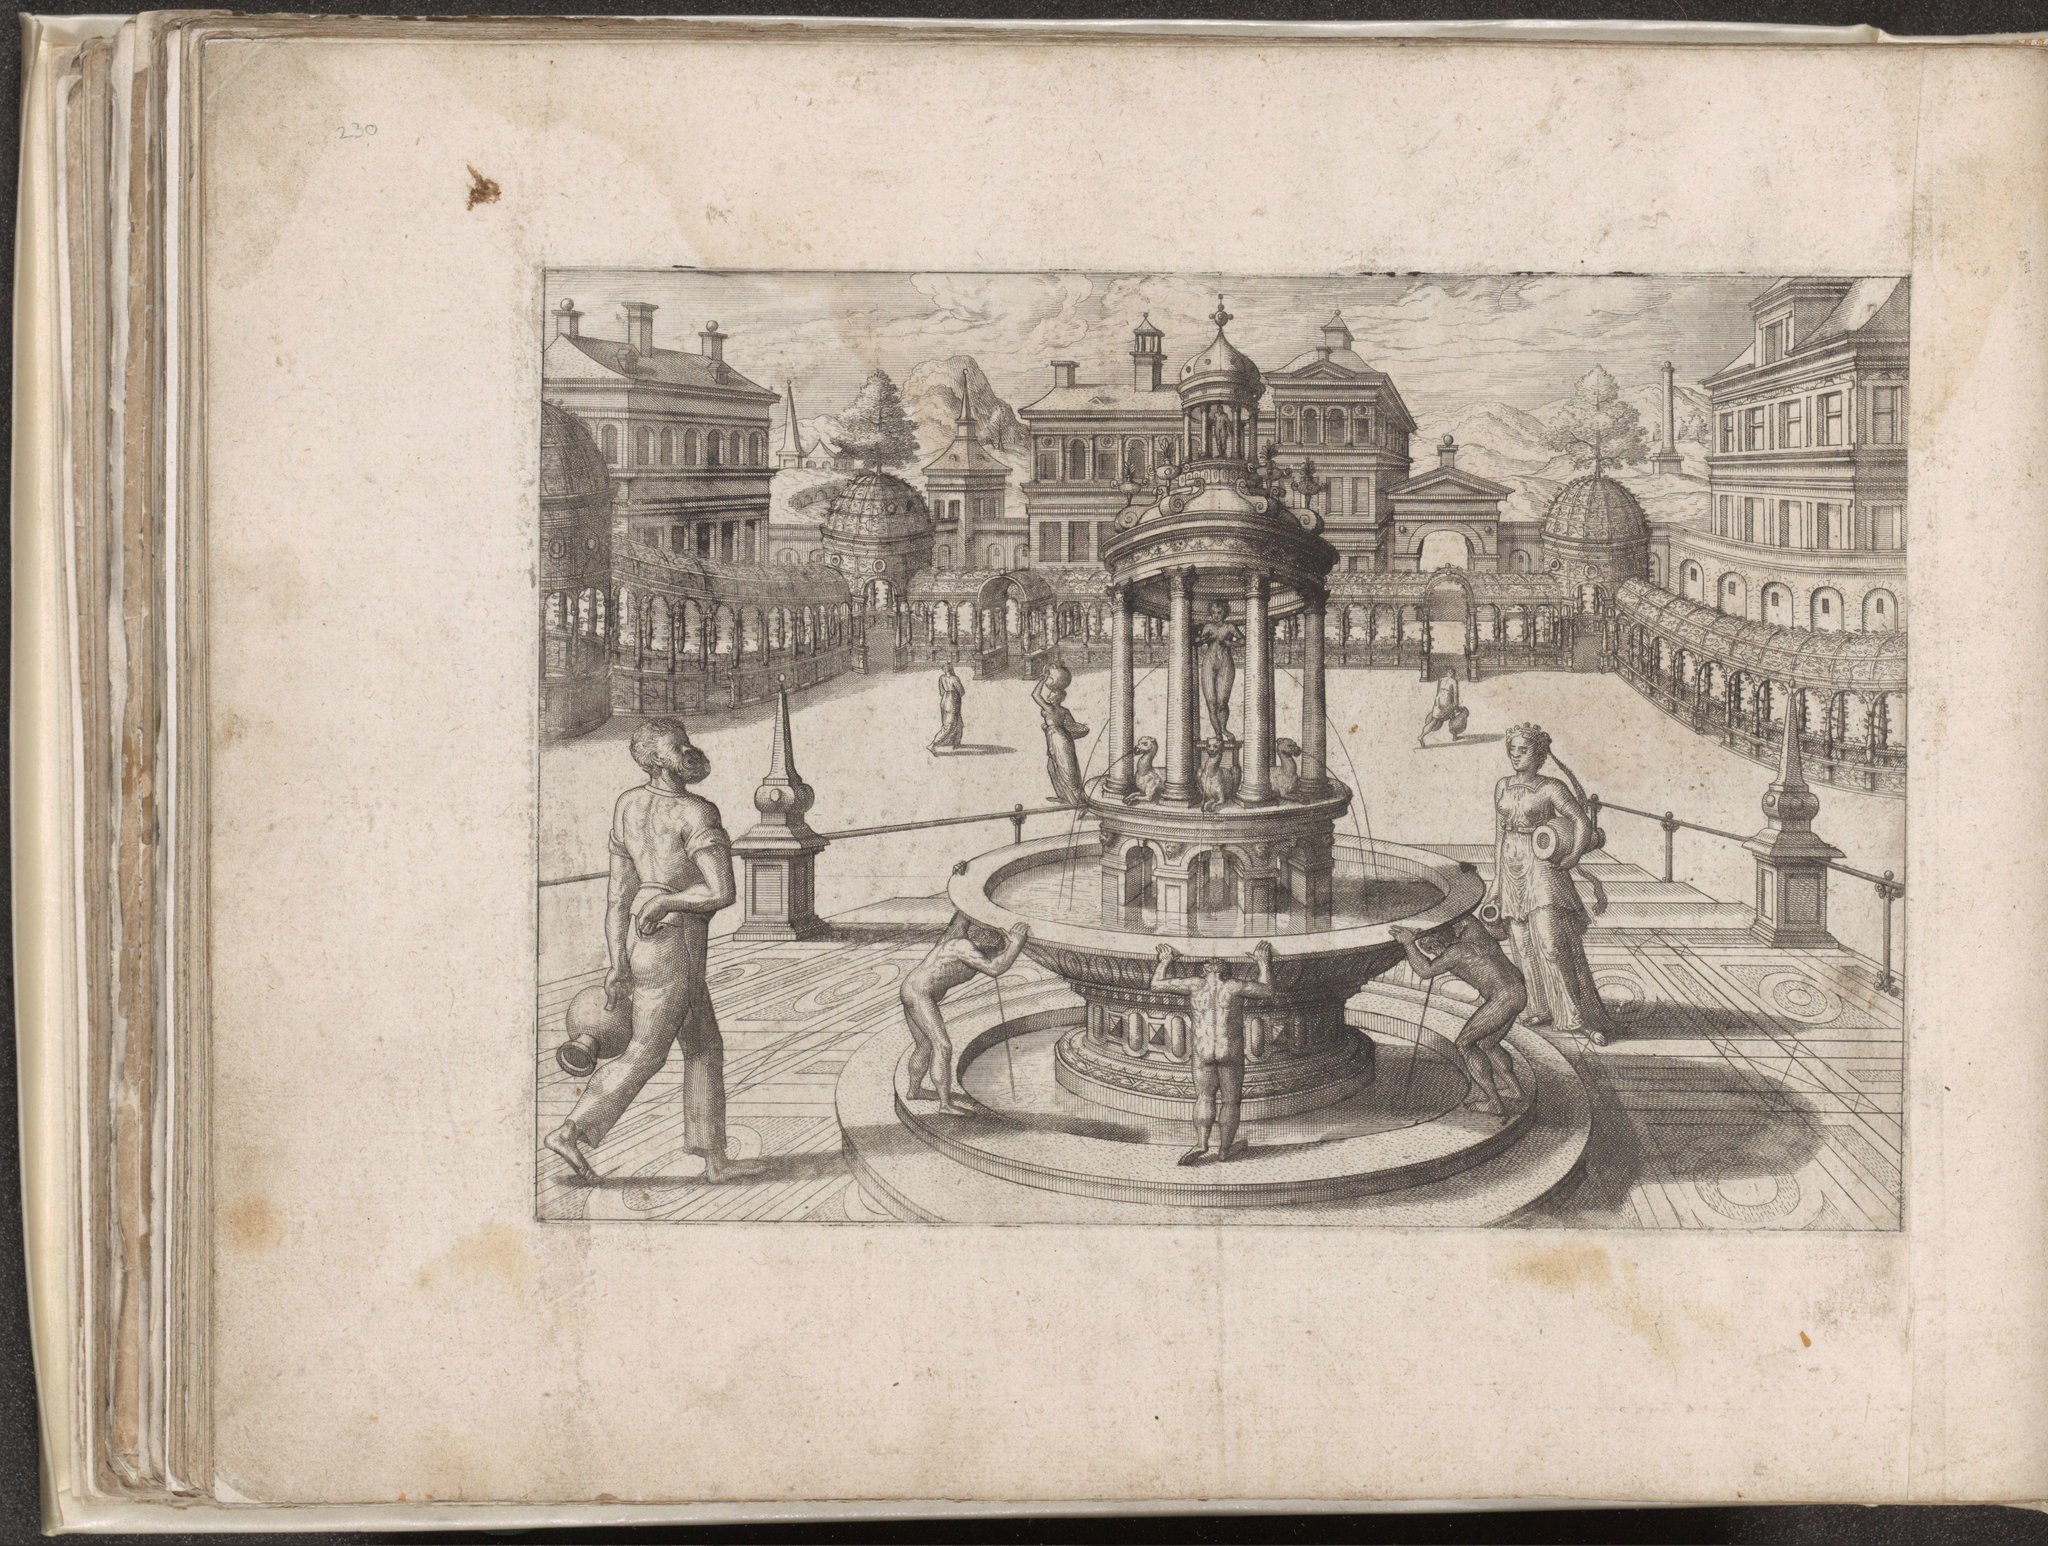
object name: album leaf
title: Artis Perspectivae (...)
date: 1568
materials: paper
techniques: etching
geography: antwerp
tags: piece of sculpture, reproduction of a piece of sculpture, ornamental fountain, village square, place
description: Op een plein staat een ronde fontein bekroond met een rond tempeltje van twee verdiepingen. In het tempeltje staat een standbeeld van een vrouw. Het bassin wordt ondersteund door vier naakte waterspuwende mannen. Bij de fontein staan figuren met kruiken. Rond het plein een gang van traliewerk. Deze prent maakt deel uit van een album.